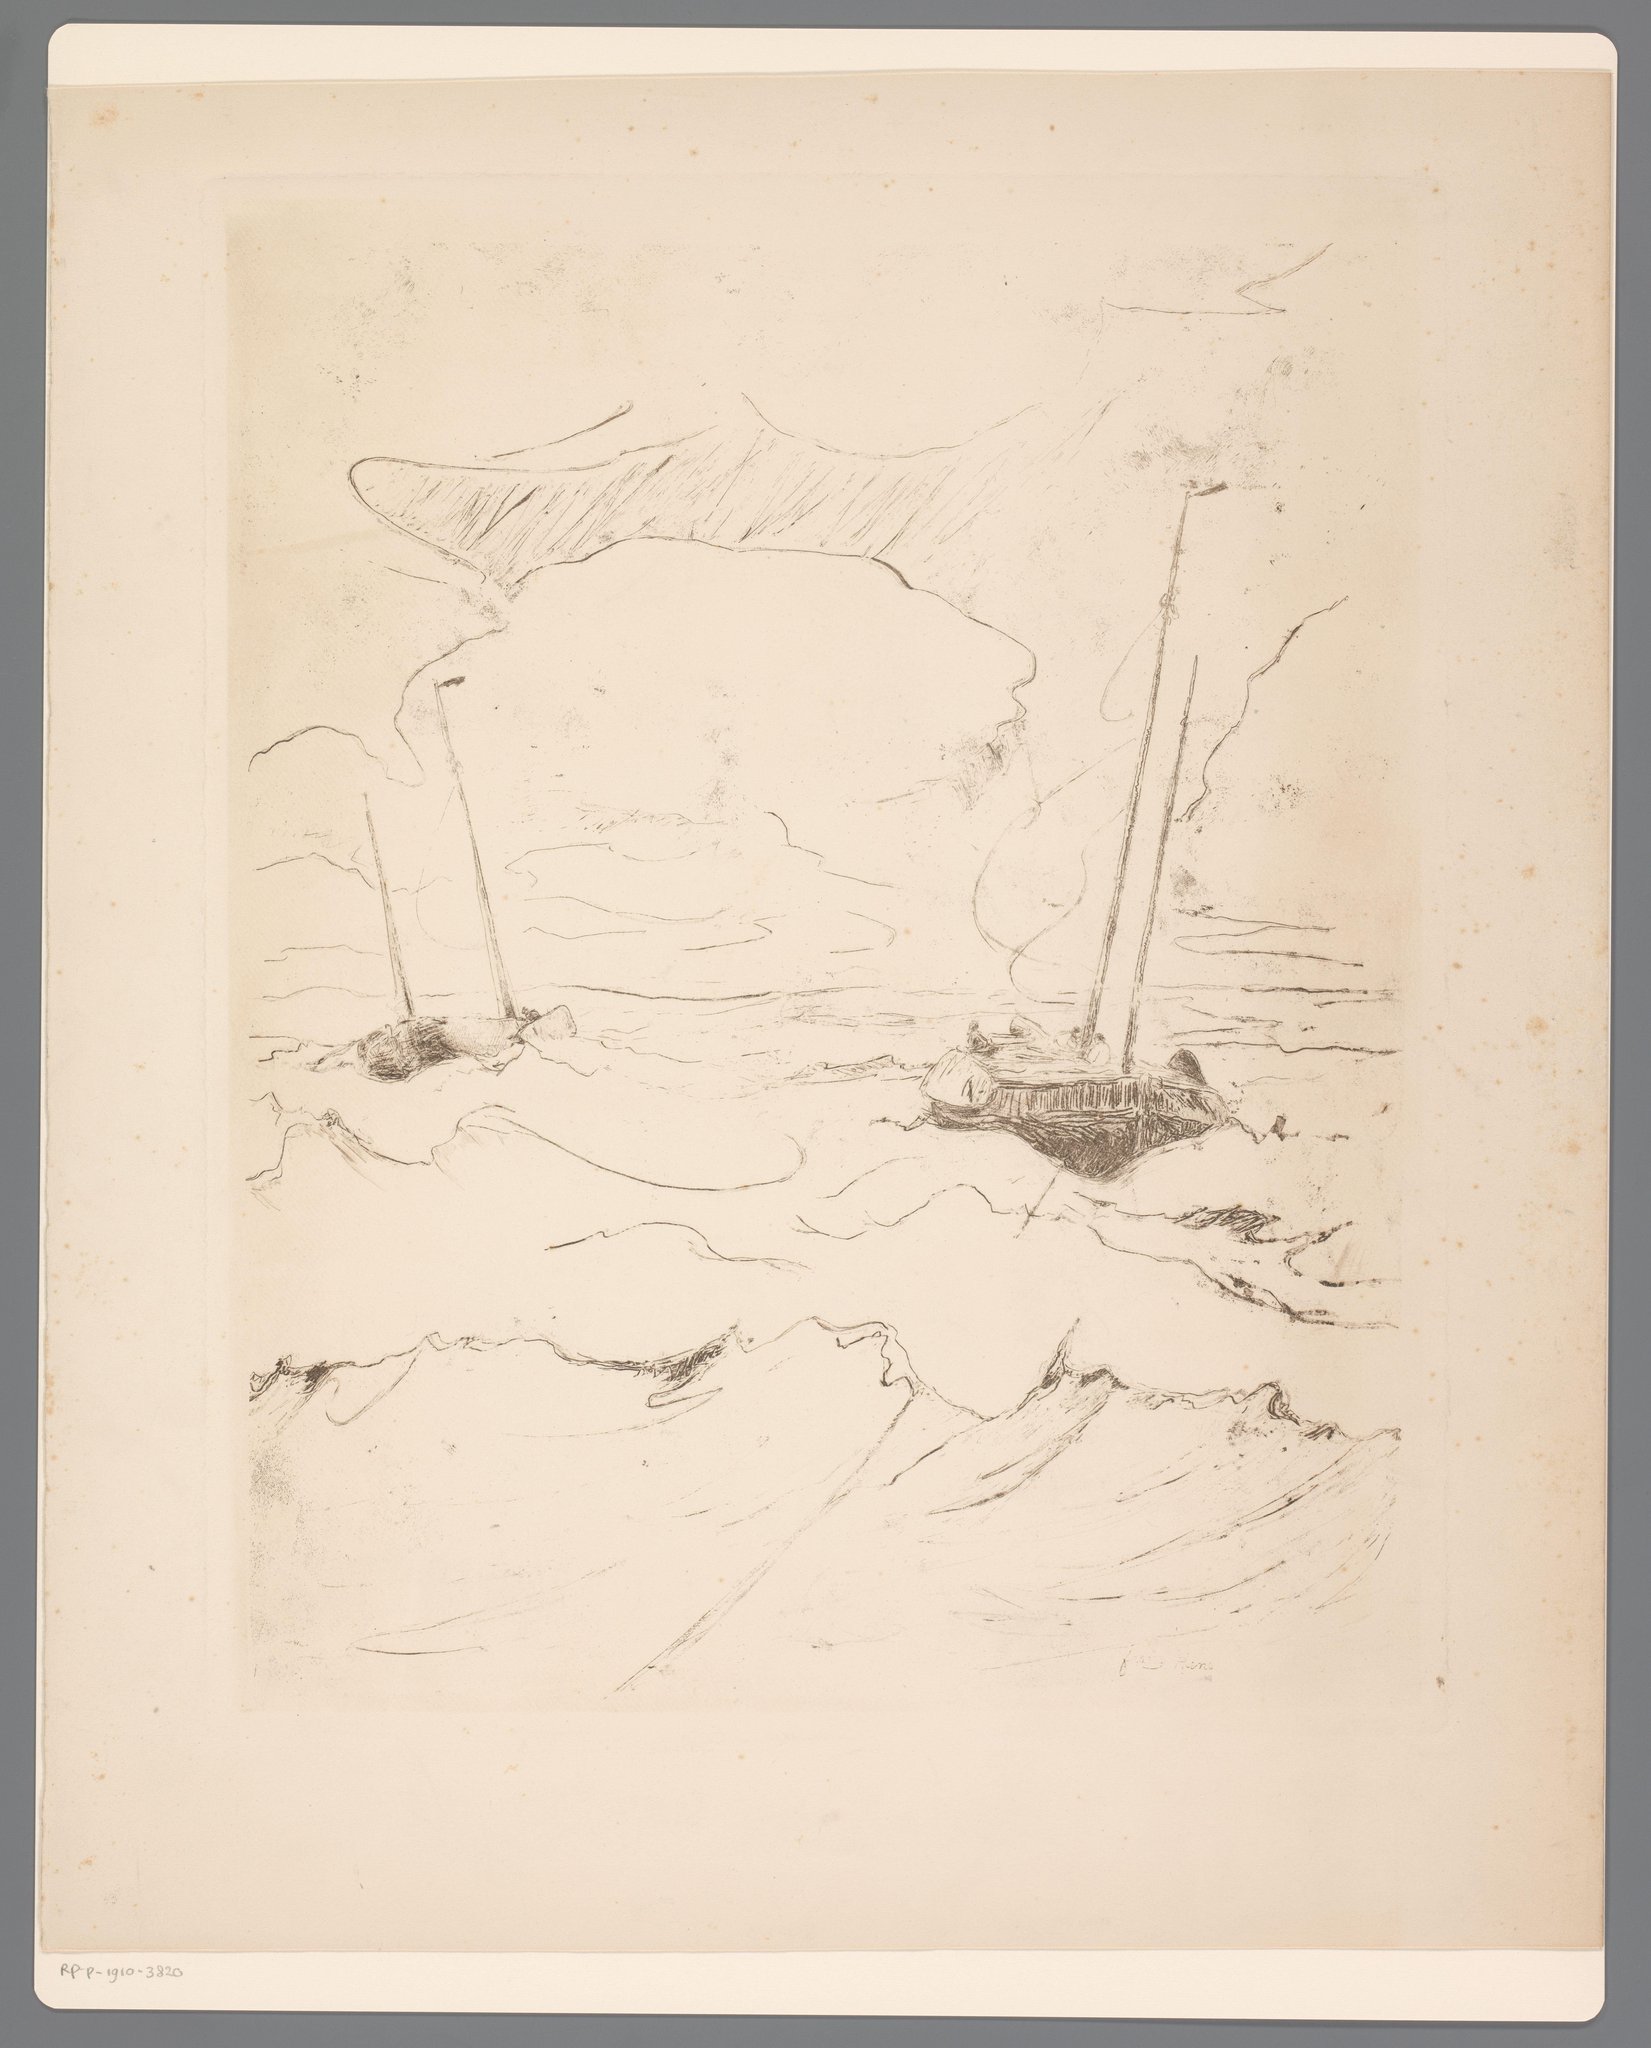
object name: print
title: Golven slaan tegen twee zeilboten op zee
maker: frans hens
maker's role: print maker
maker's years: 1856-1928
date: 1866-1910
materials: paper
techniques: etching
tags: wave, sailing-ship, sailing-boat, landscapes with waters, waterscapes, seascapes (in the temperate zone)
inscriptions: collector's mark: Lugt 2228